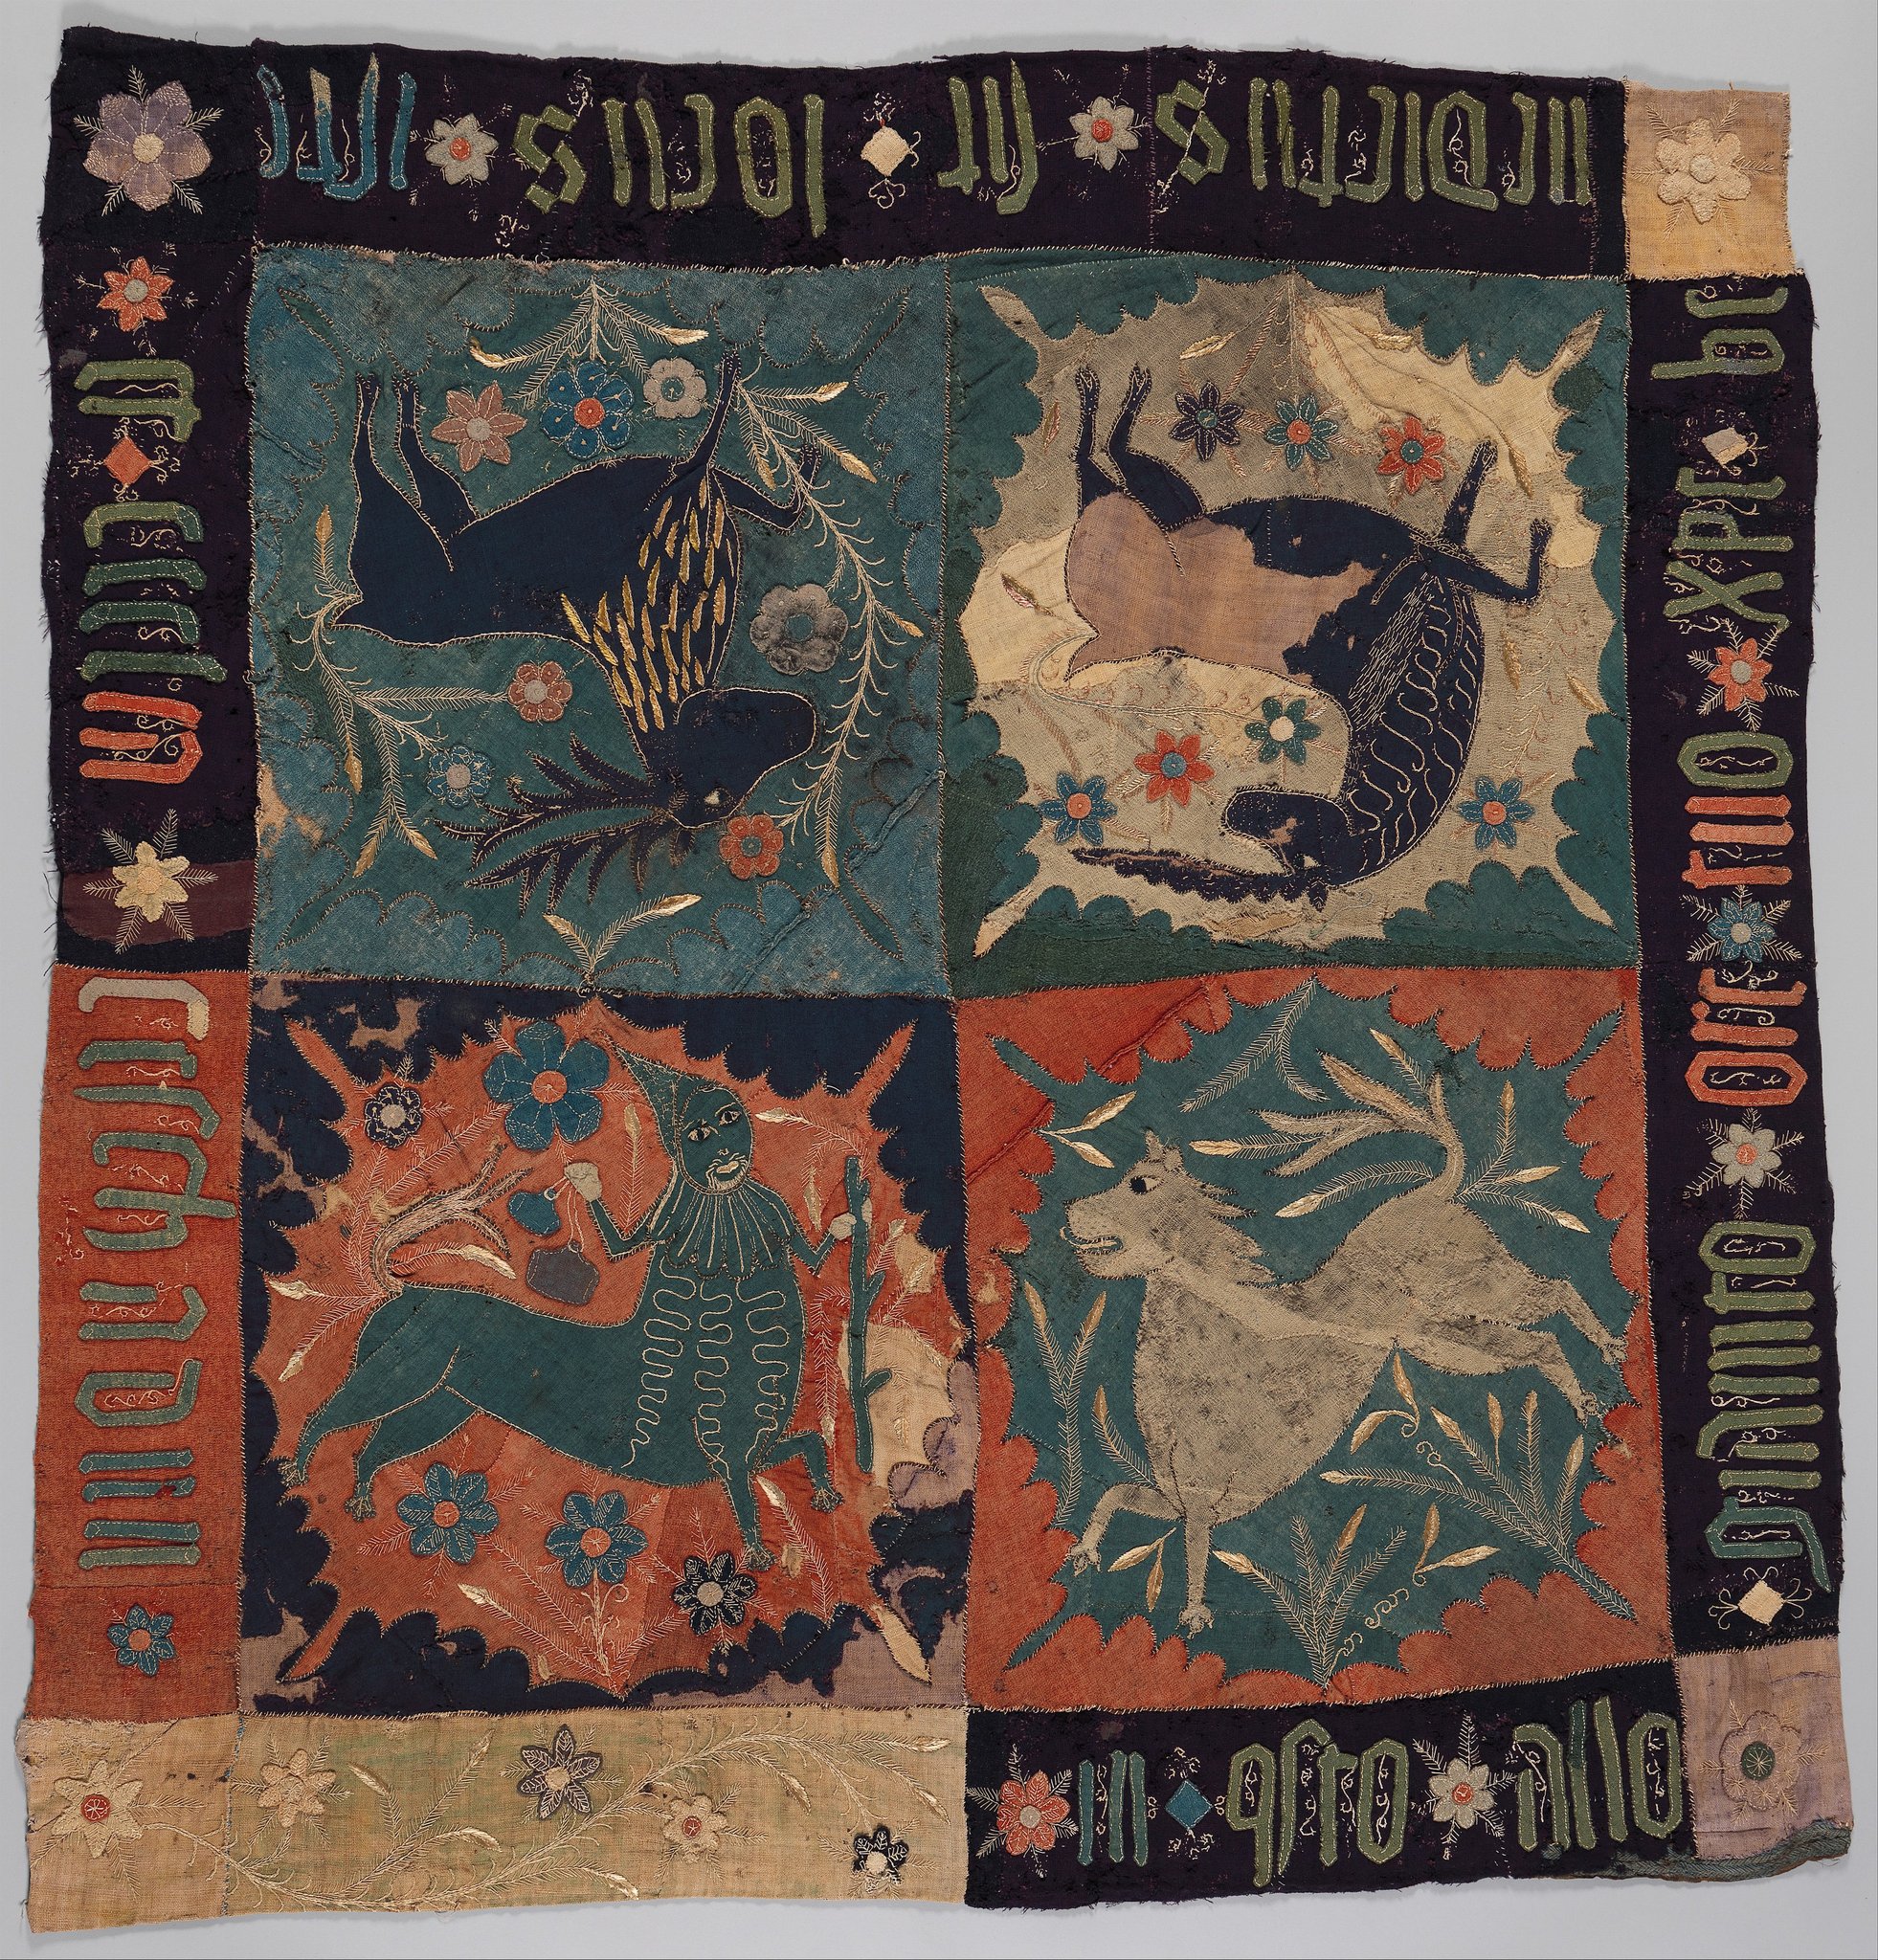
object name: fragment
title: Textile Fragment with Unicorn, Deer, Centaur and Lion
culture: scandinavian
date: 1500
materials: gilt, leather, linen, wool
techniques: embroidery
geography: scandinavia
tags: centaurs,unicorns,deer,lions